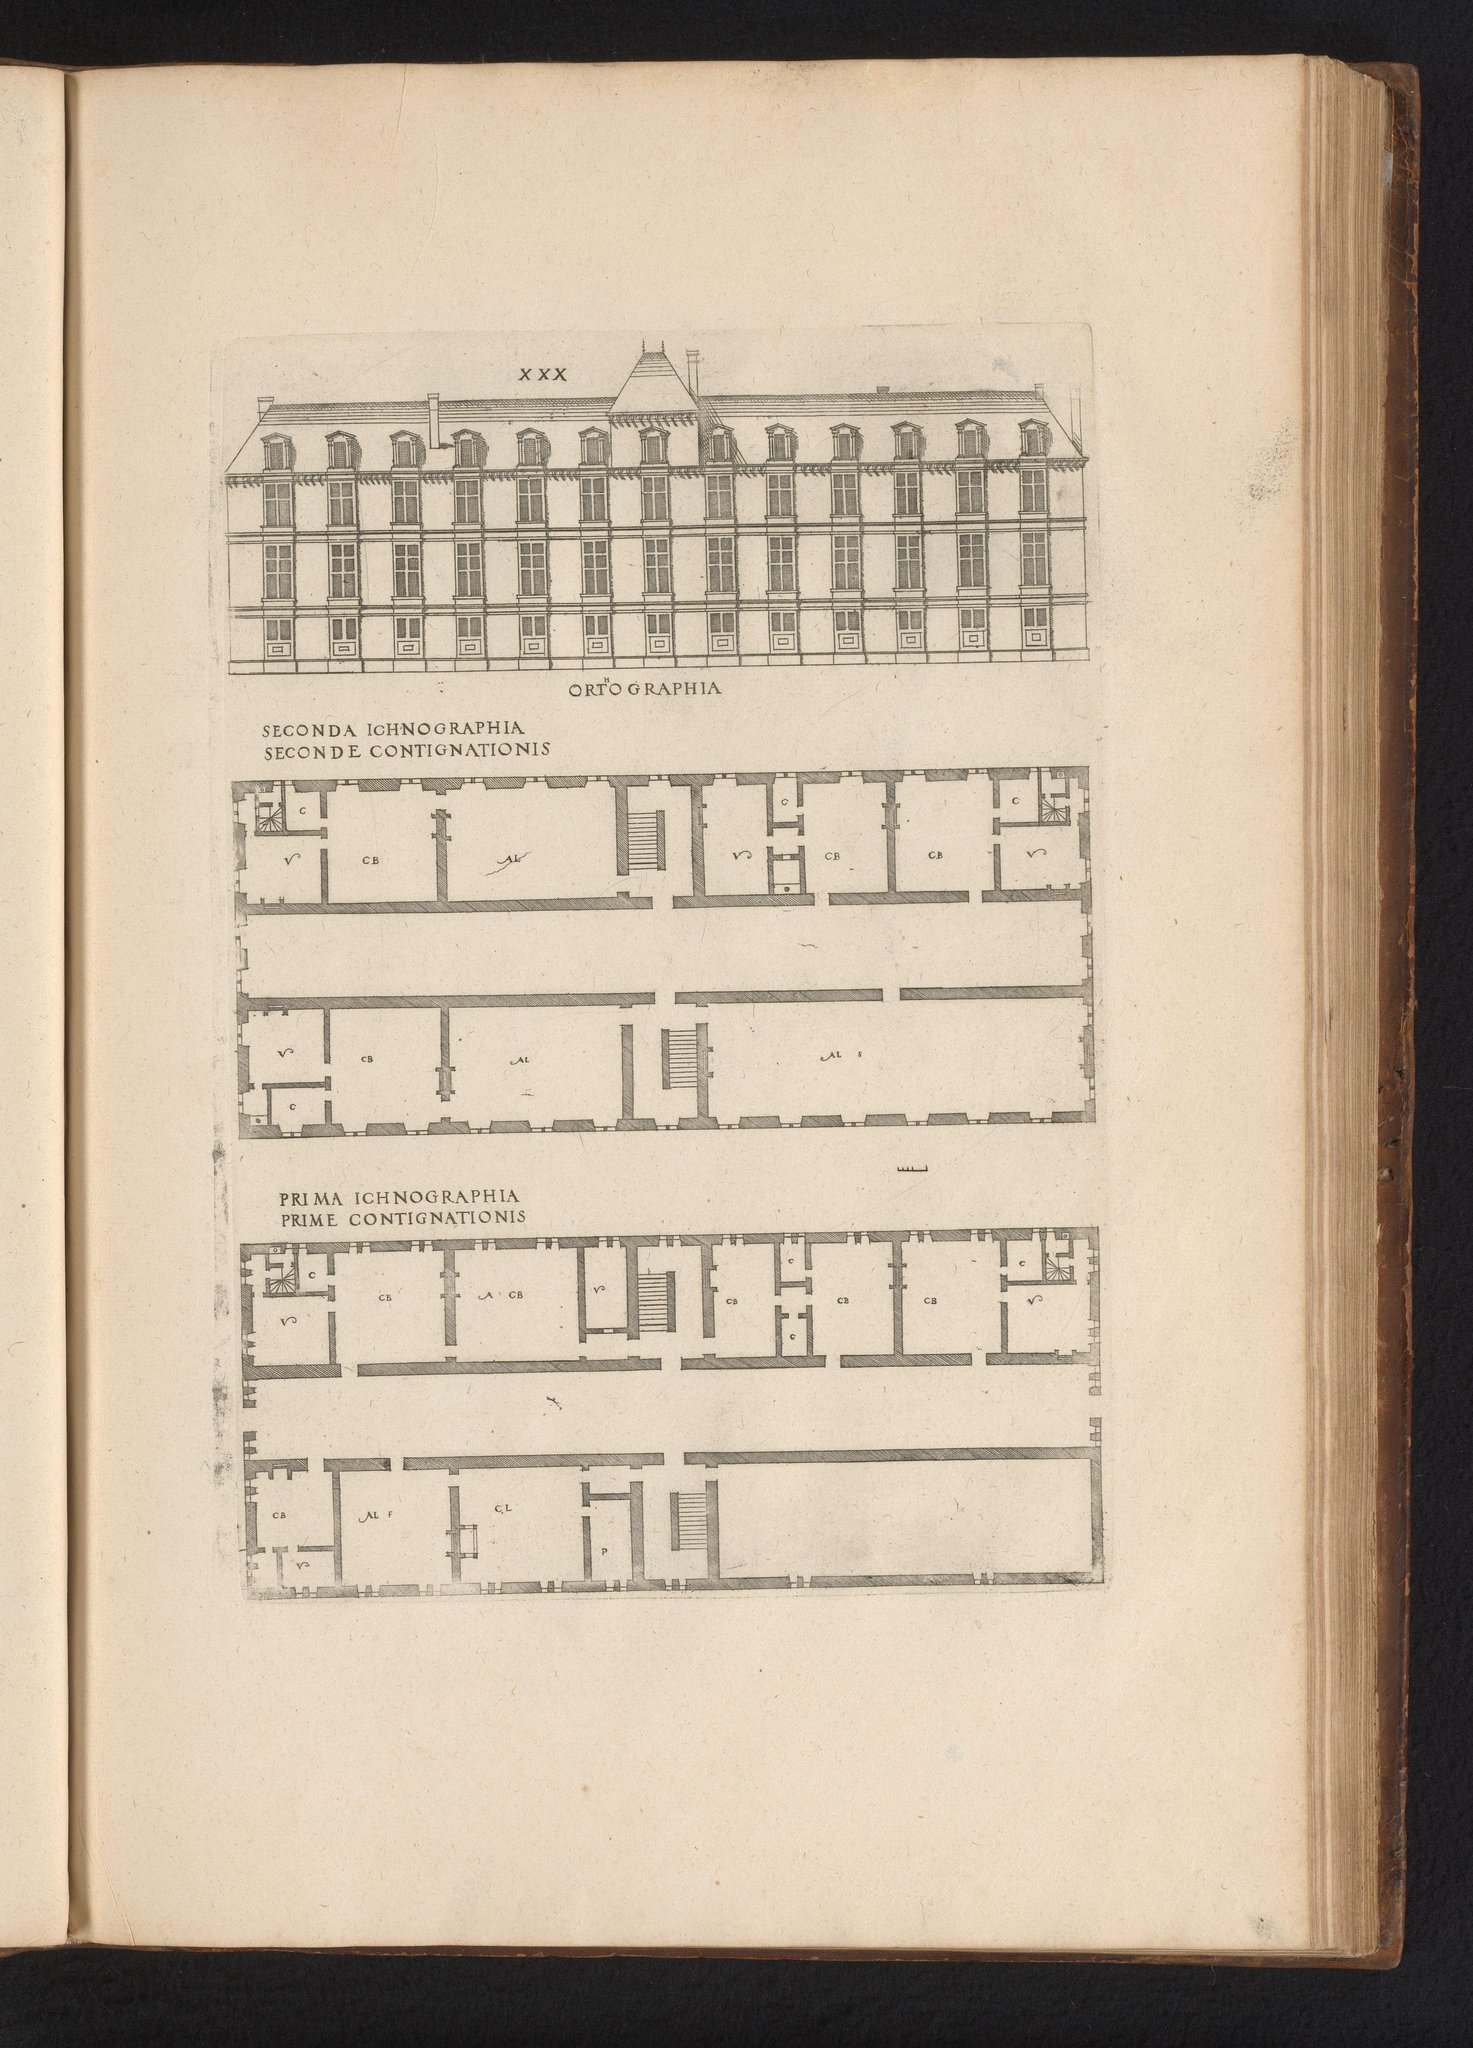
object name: ornament print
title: Gevel en plattegronden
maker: jacques androuet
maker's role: draughtsman, print maker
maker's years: 1515-1584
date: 1559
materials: paper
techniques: etching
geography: paris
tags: façade (of house or building), plan ~ architecture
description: Gevel en twee plattegronden. Aanzicht en plattegrond van architectuur. Genummerd: XXX. Onderdeel van 'De architectura Iacobi Androuetii du Cerceau' (1559): 69 etsen met 171 voorstellingen van architectuur en ornamentiek.